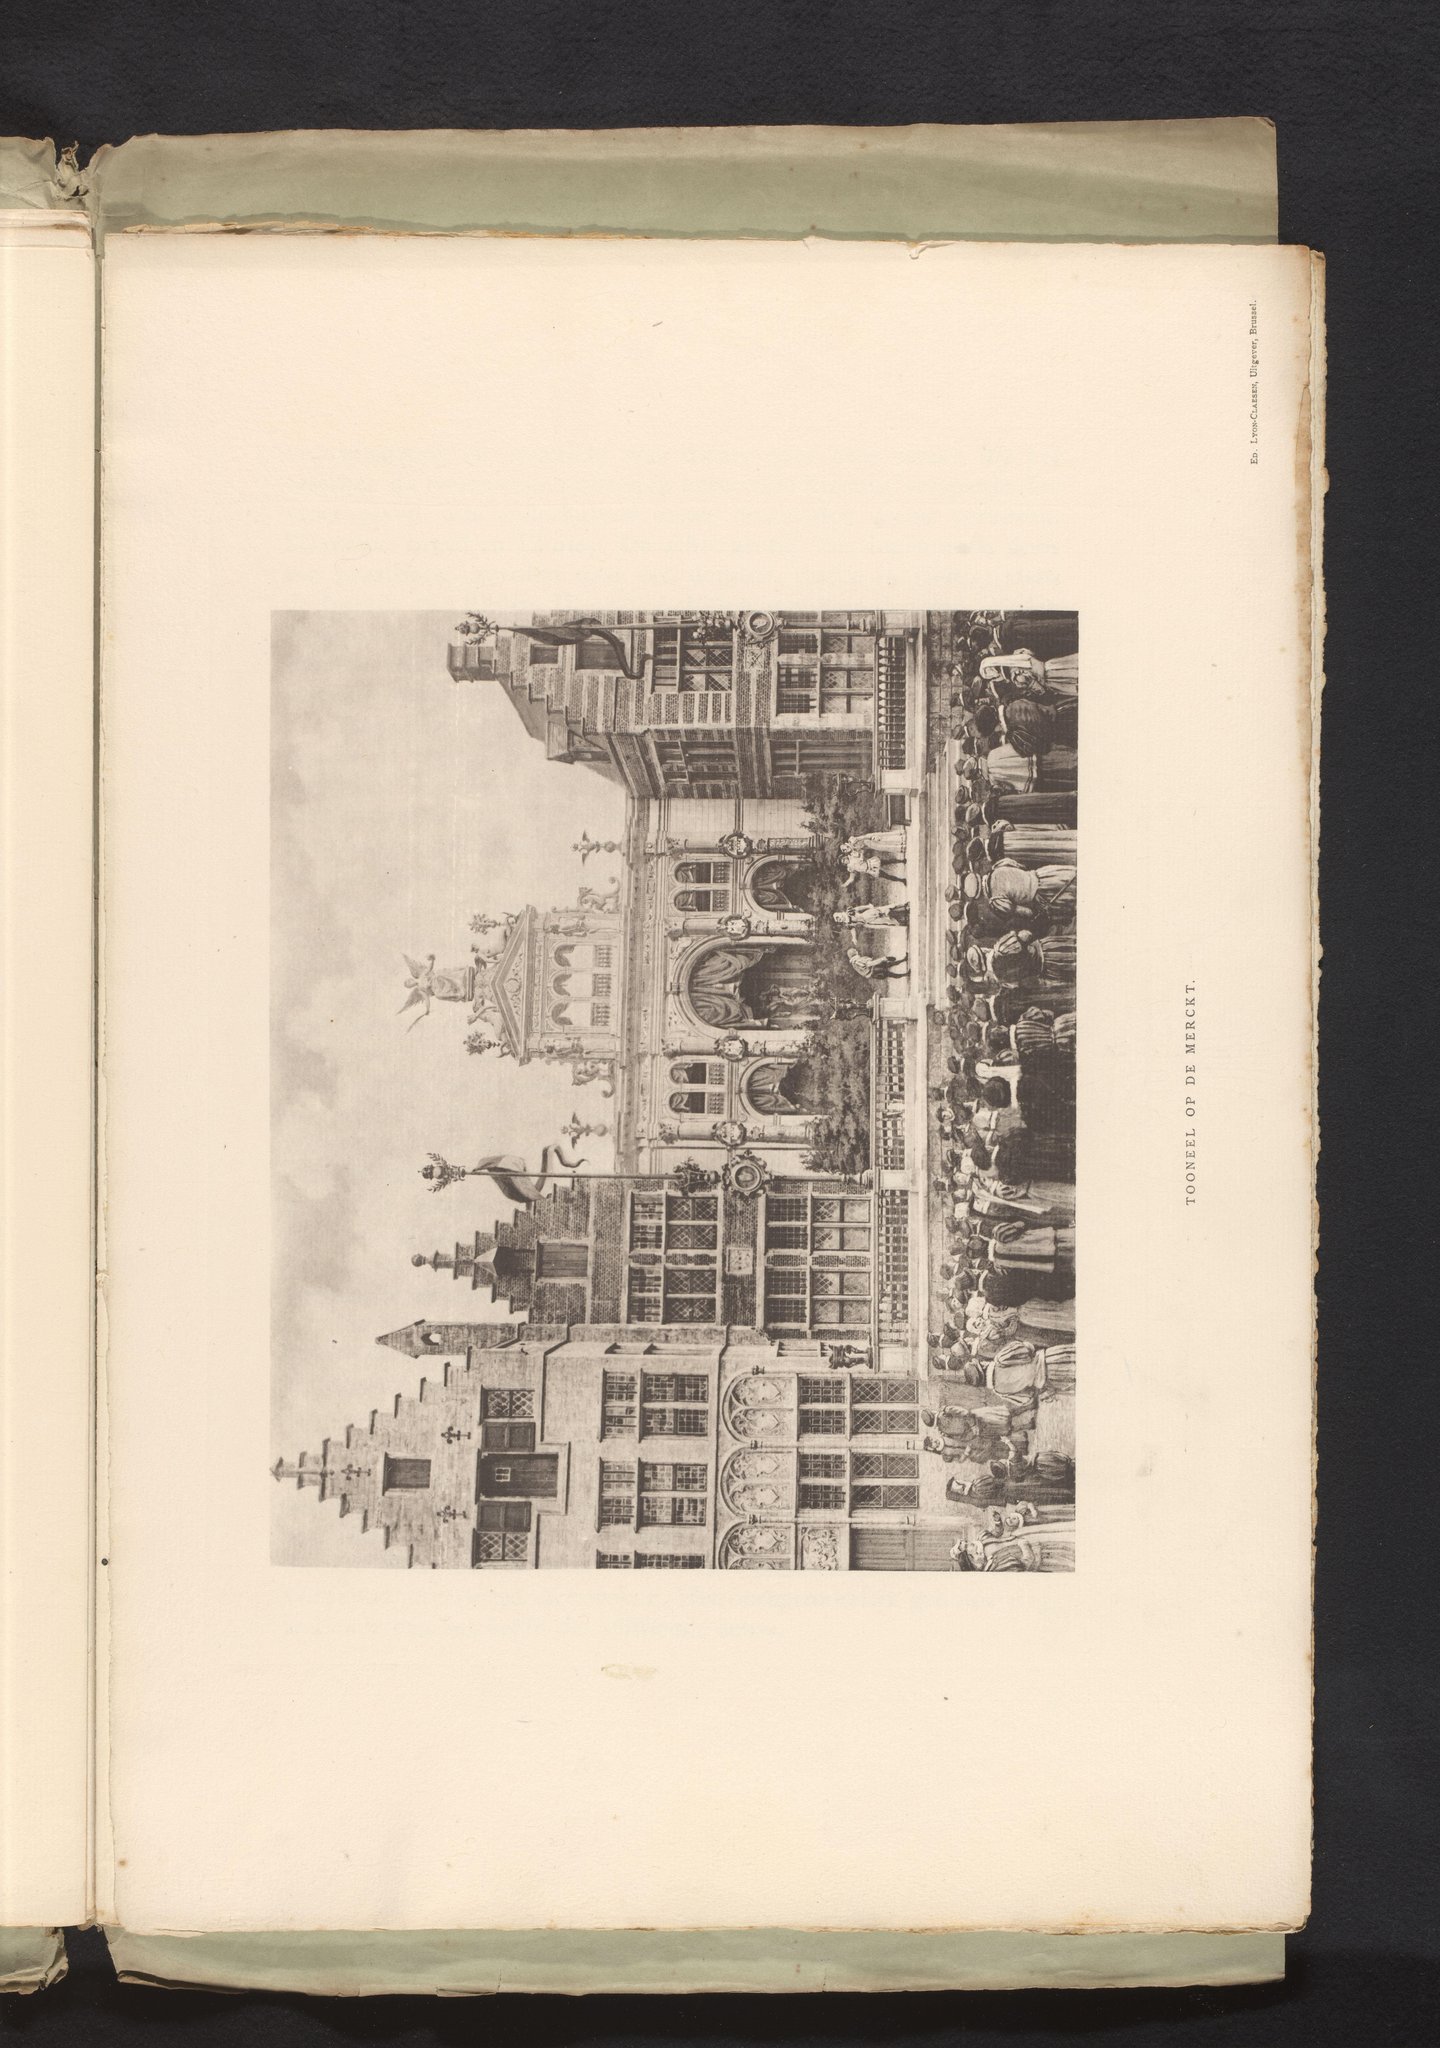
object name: page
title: Gezicht op een toneelstuk opgevoerd op de markt van Oud-Antwerpen op de Wereldtentoonstelling van 1894 in Antwerpen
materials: paper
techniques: photograph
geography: antwerp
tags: theatre, theatrical performance, world fair, world exhibition, antwerp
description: Prent op los blad tussen pagina 36 en 37.